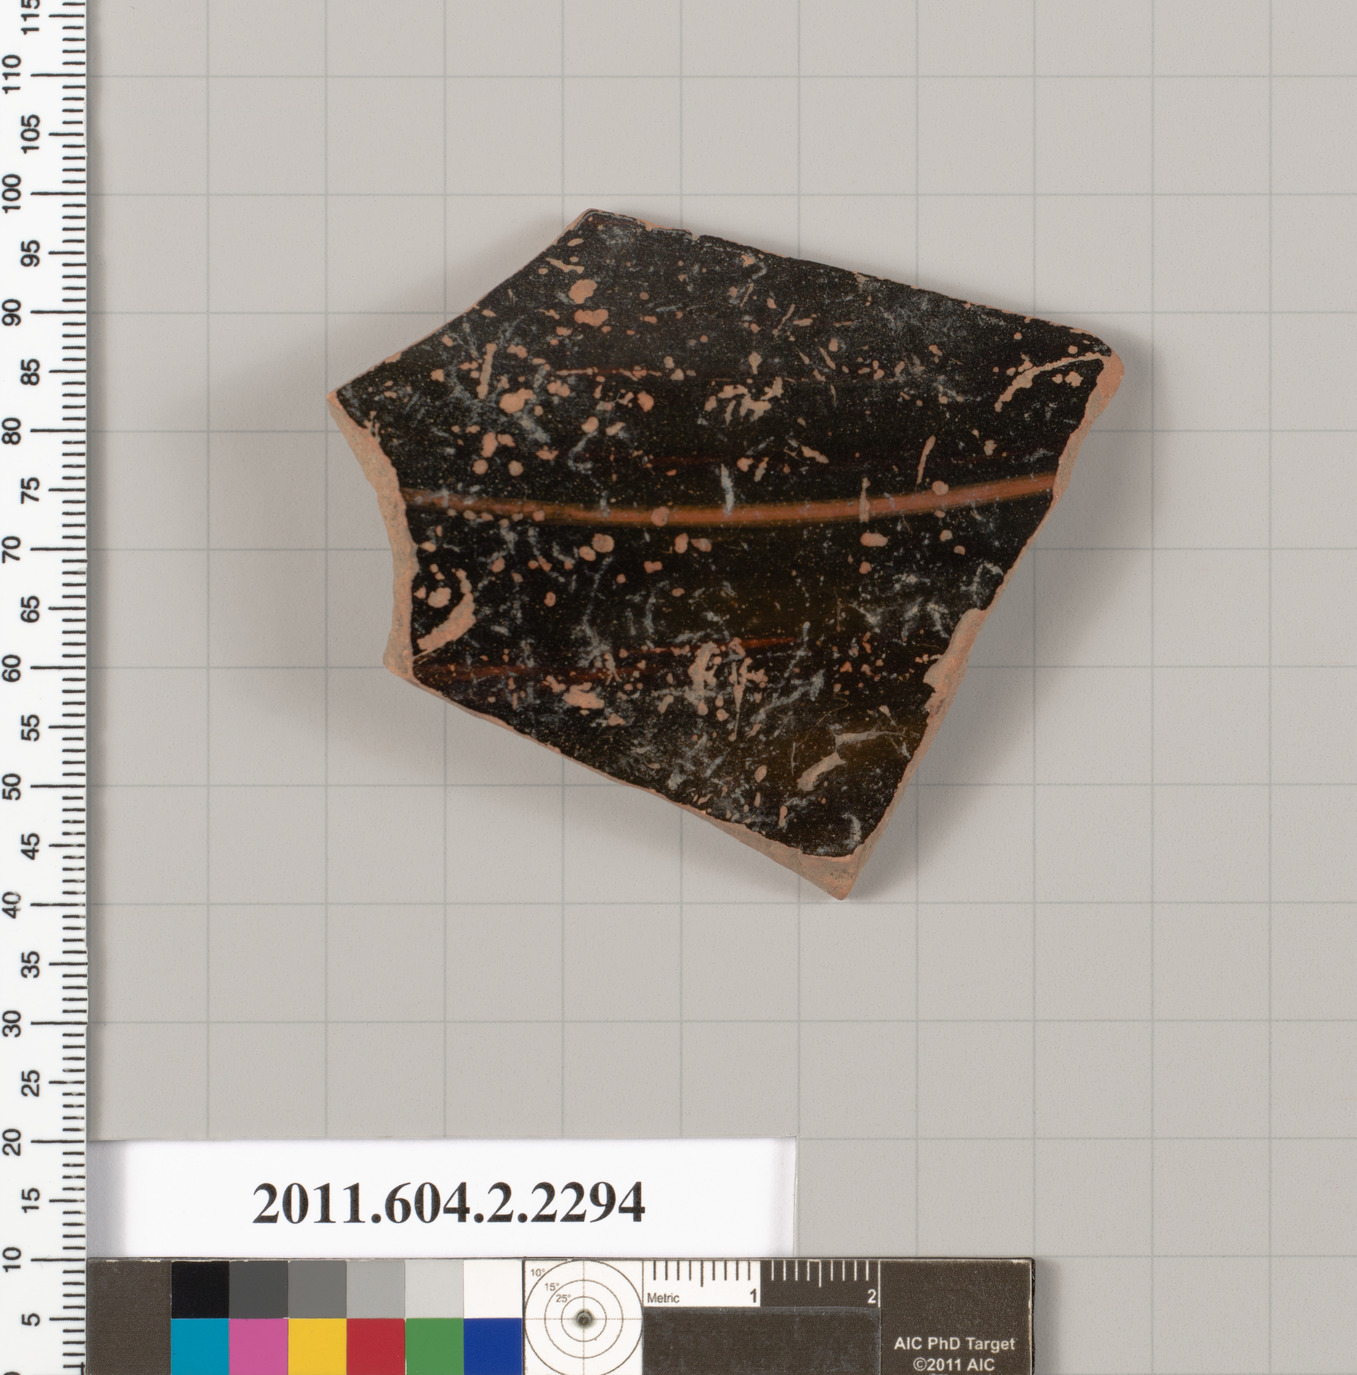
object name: pot fragment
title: Terracotta fragment of a pot; glazed on the inside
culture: greek, attic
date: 475-451 BCE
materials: terracotta